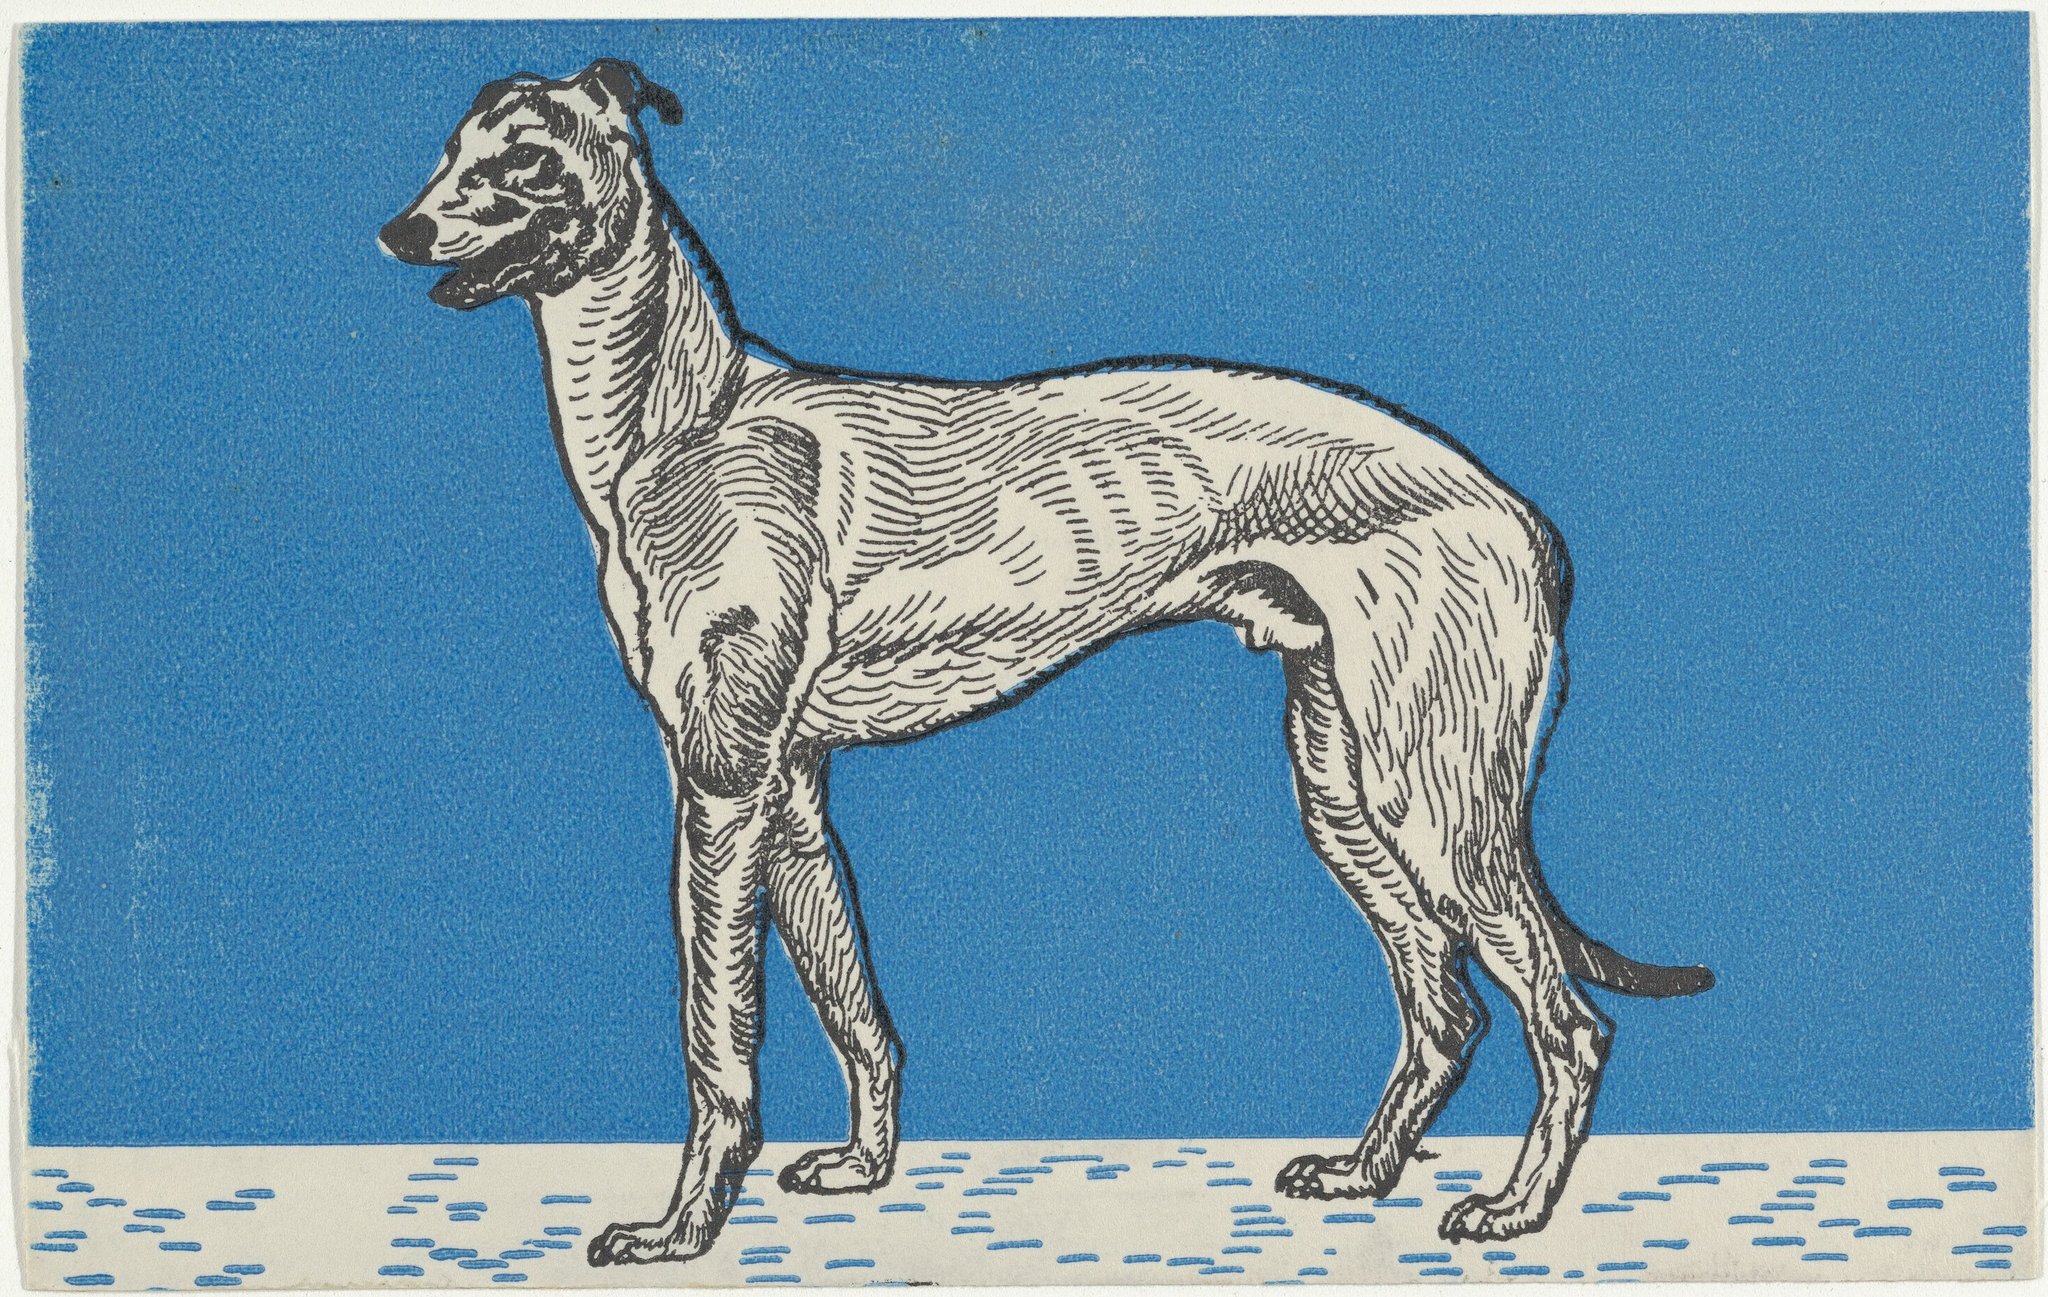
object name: print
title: Greyhound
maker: moriz jung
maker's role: artist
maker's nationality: austrian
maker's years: 1885-1915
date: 1912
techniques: lithograph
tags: dogs